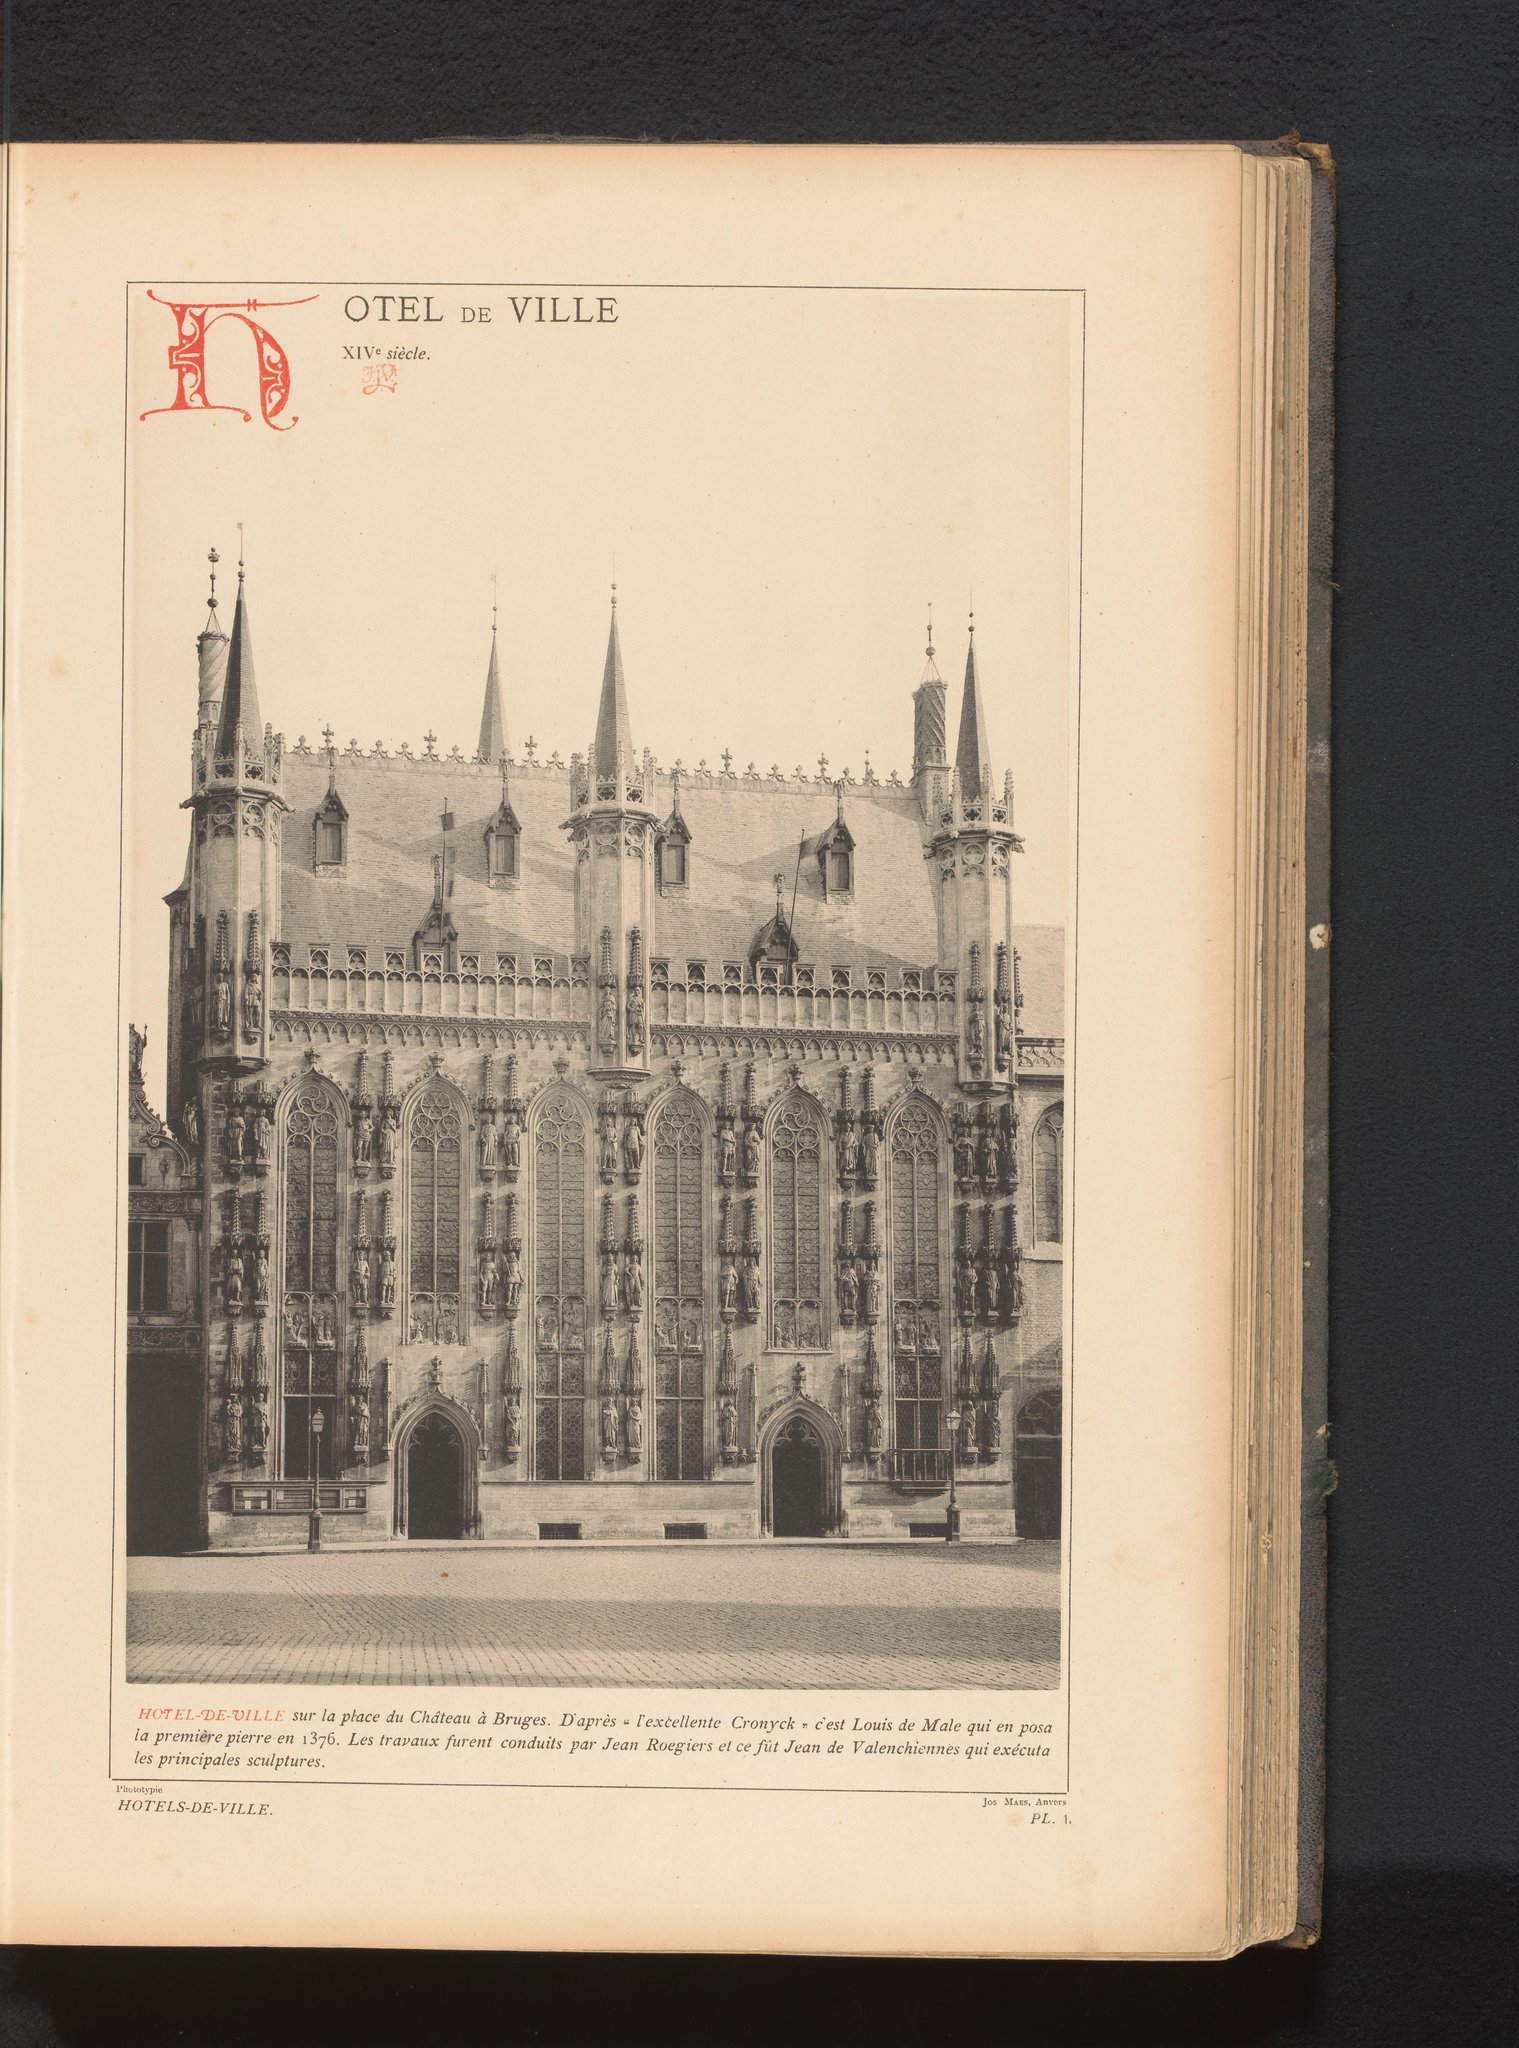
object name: photomechanical print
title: Gezicht op het stadhuis van Brugge, België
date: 1882-1887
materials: paper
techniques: photograph, photolithography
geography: bruges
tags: townhall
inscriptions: inscription: ‘HOTELS-DE-VILLE. - PL. 1.’, inscription: ‘HOTEL-DE-VILLE sur la (...)’, monogram: ‘JJvY’